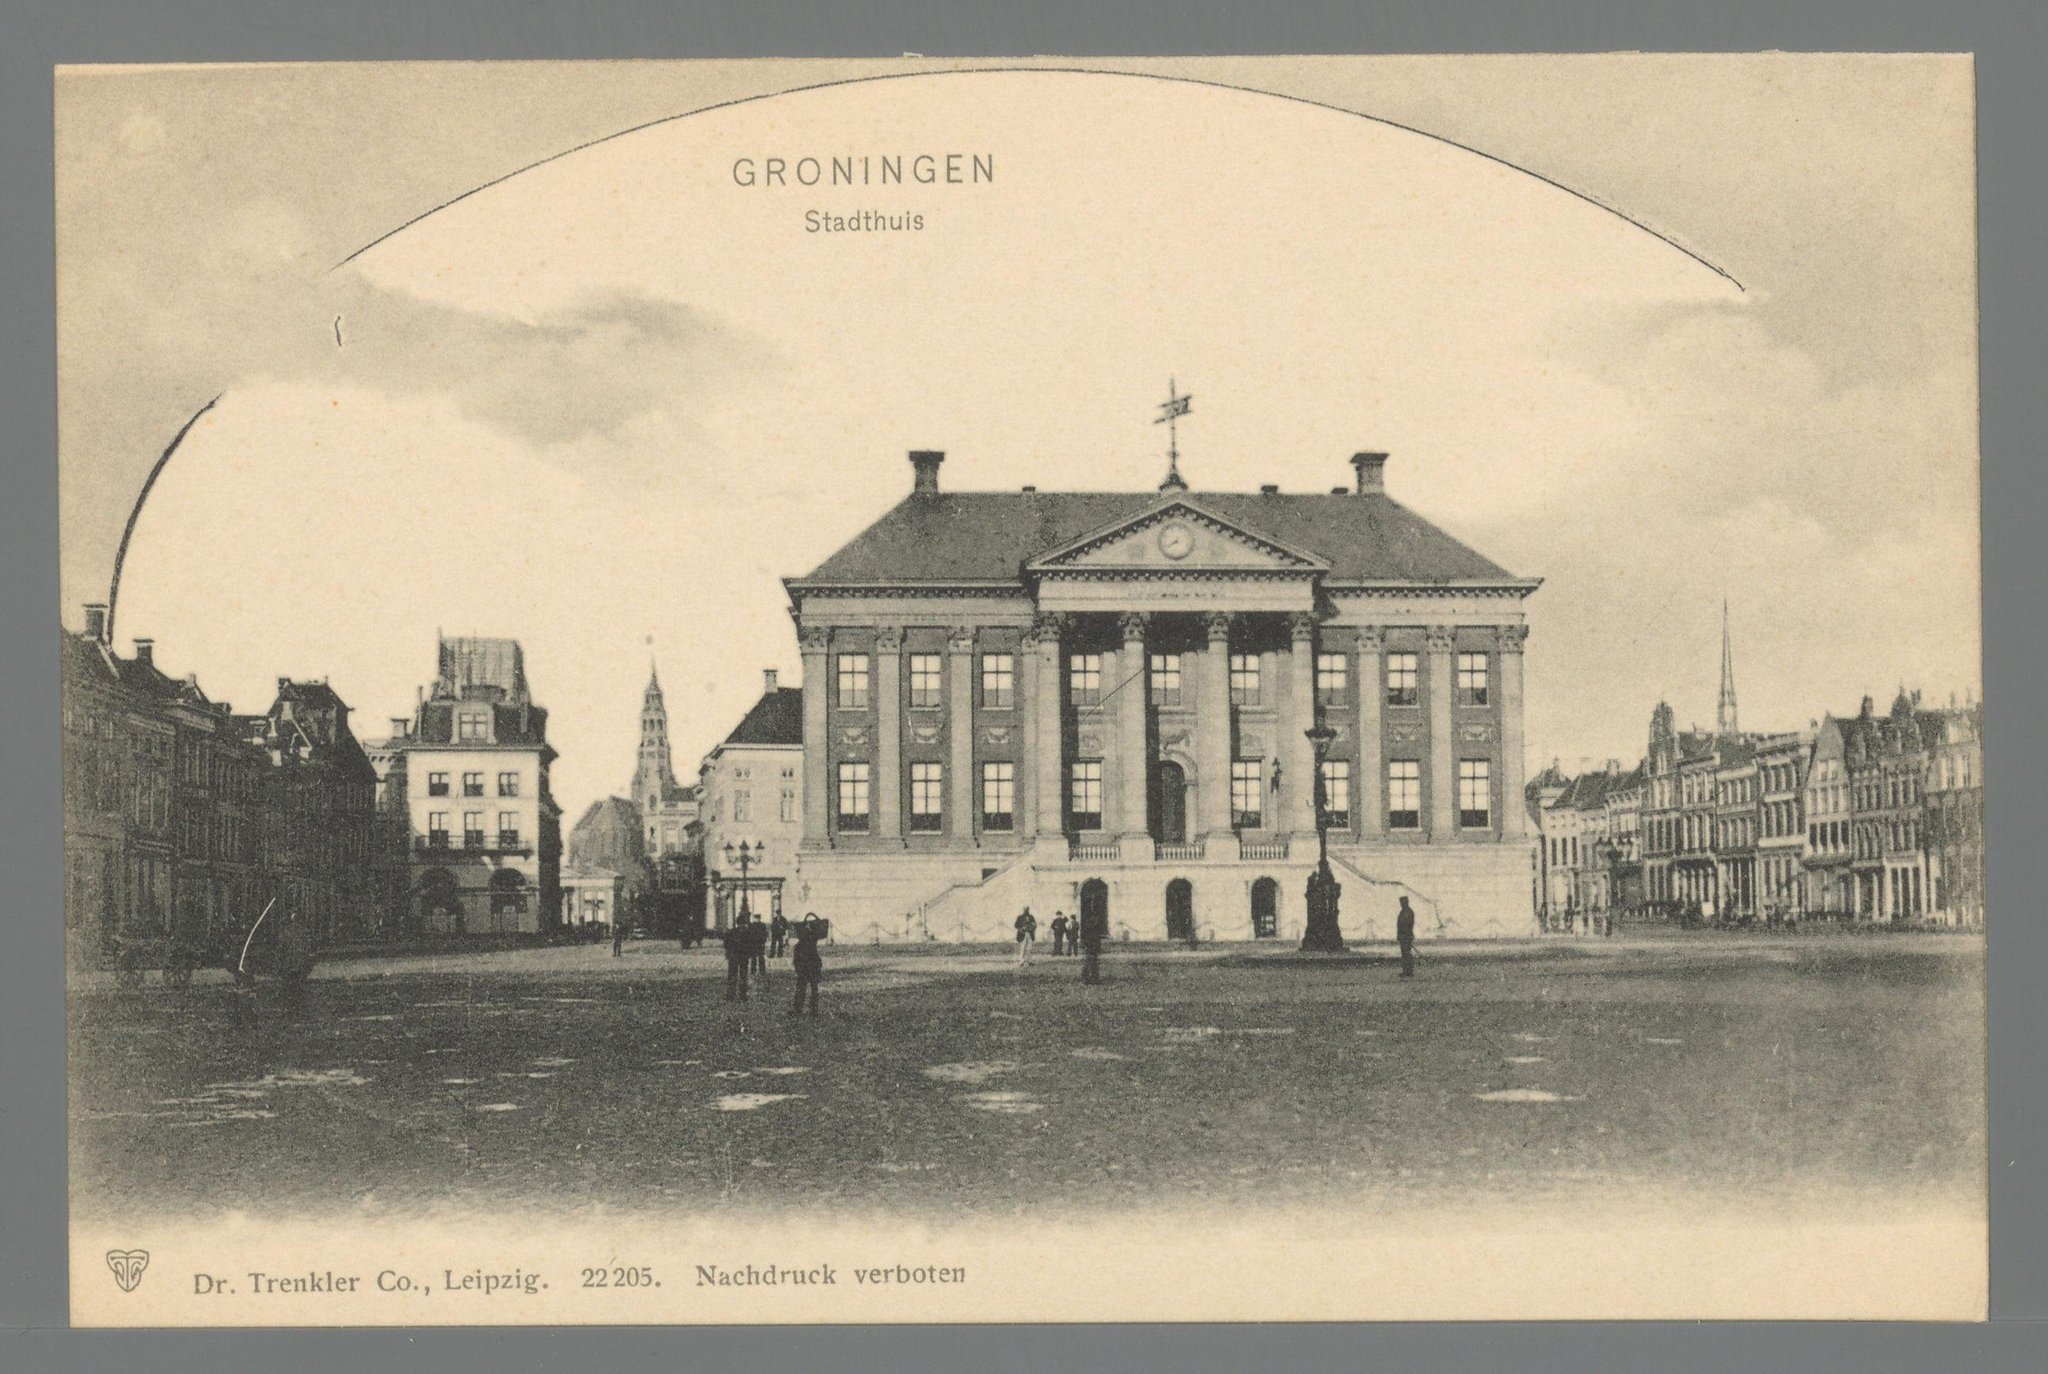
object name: ansichtkaart, prentbriefkaart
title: Groningen. Stadthuis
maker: Anonymous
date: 1892-1905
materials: cardboard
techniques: photograph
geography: groningen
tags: square, place, circus, etc., church (exterior), townhall